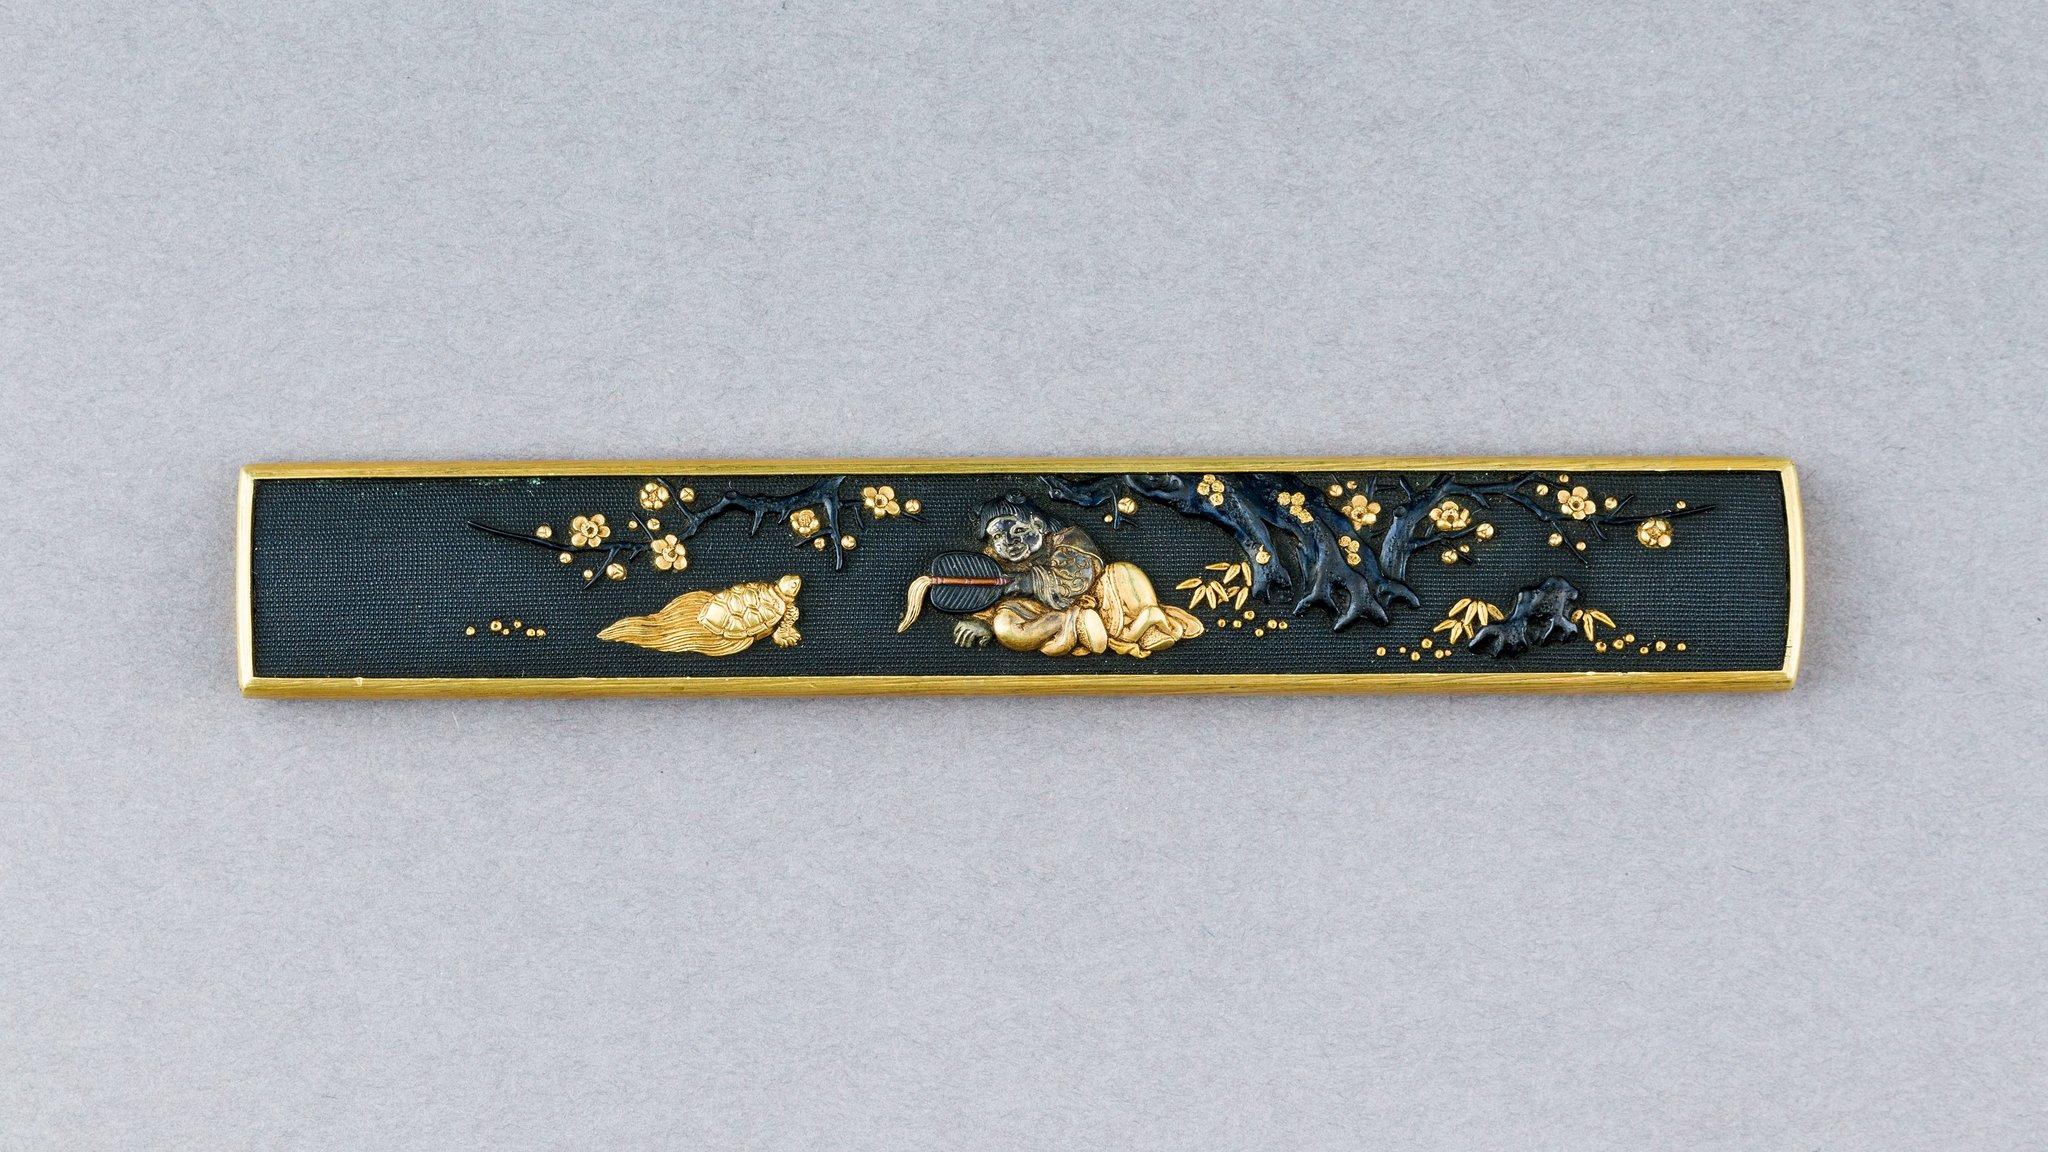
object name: knife handle kozuka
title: Knife Handle (Kozuka)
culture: japanese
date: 1615-1868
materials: copper, gold alloy, gold, silver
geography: japan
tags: human figures,turtles,trees